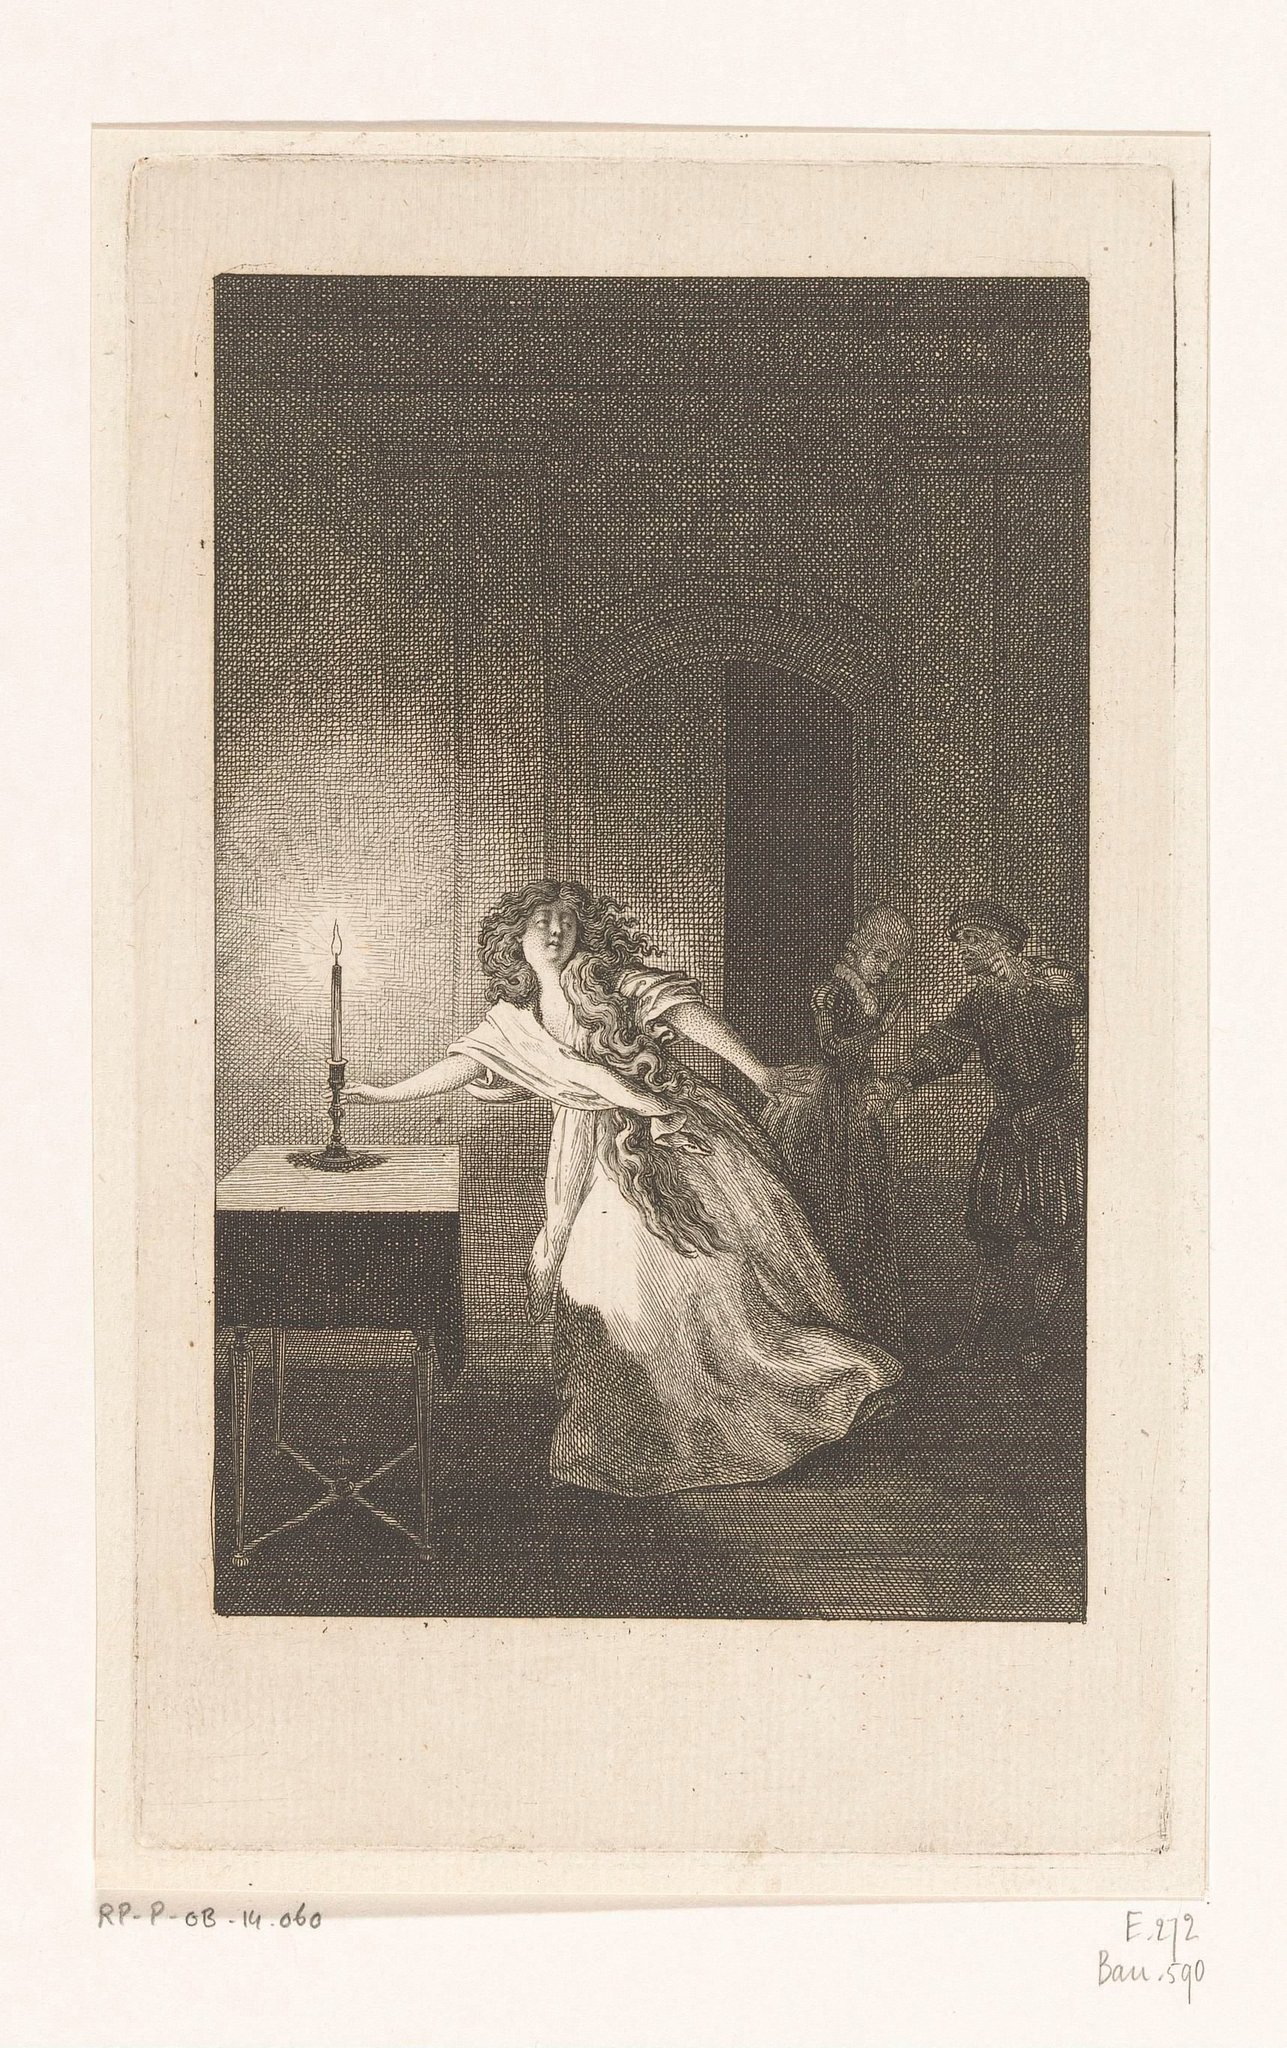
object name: print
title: Lady Macbeth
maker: daniel nikolaus chodowiecki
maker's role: draughtsman, print maker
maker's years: 1726-1801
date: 1778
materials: paper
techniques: etching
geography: berlin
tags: william shakespeare, sleepwalking, macbeth, candlestick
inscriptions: collector's mark: Lugt 240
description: Een latere staat van deze prent is ook gebruikt in: Litteratur- und Theater-Zeitung. Zweiter Jahrgang. Berlijn: Arnold Wever, 1779. In december 1777 werd Hamlet voor het eerst in Berlijn uitgevoerd met Johann Franz Hieronymus Brockmann in de hoofdrol. Chodowiecki bezocht verschillende uitvoeringen van dit toneelstuk.